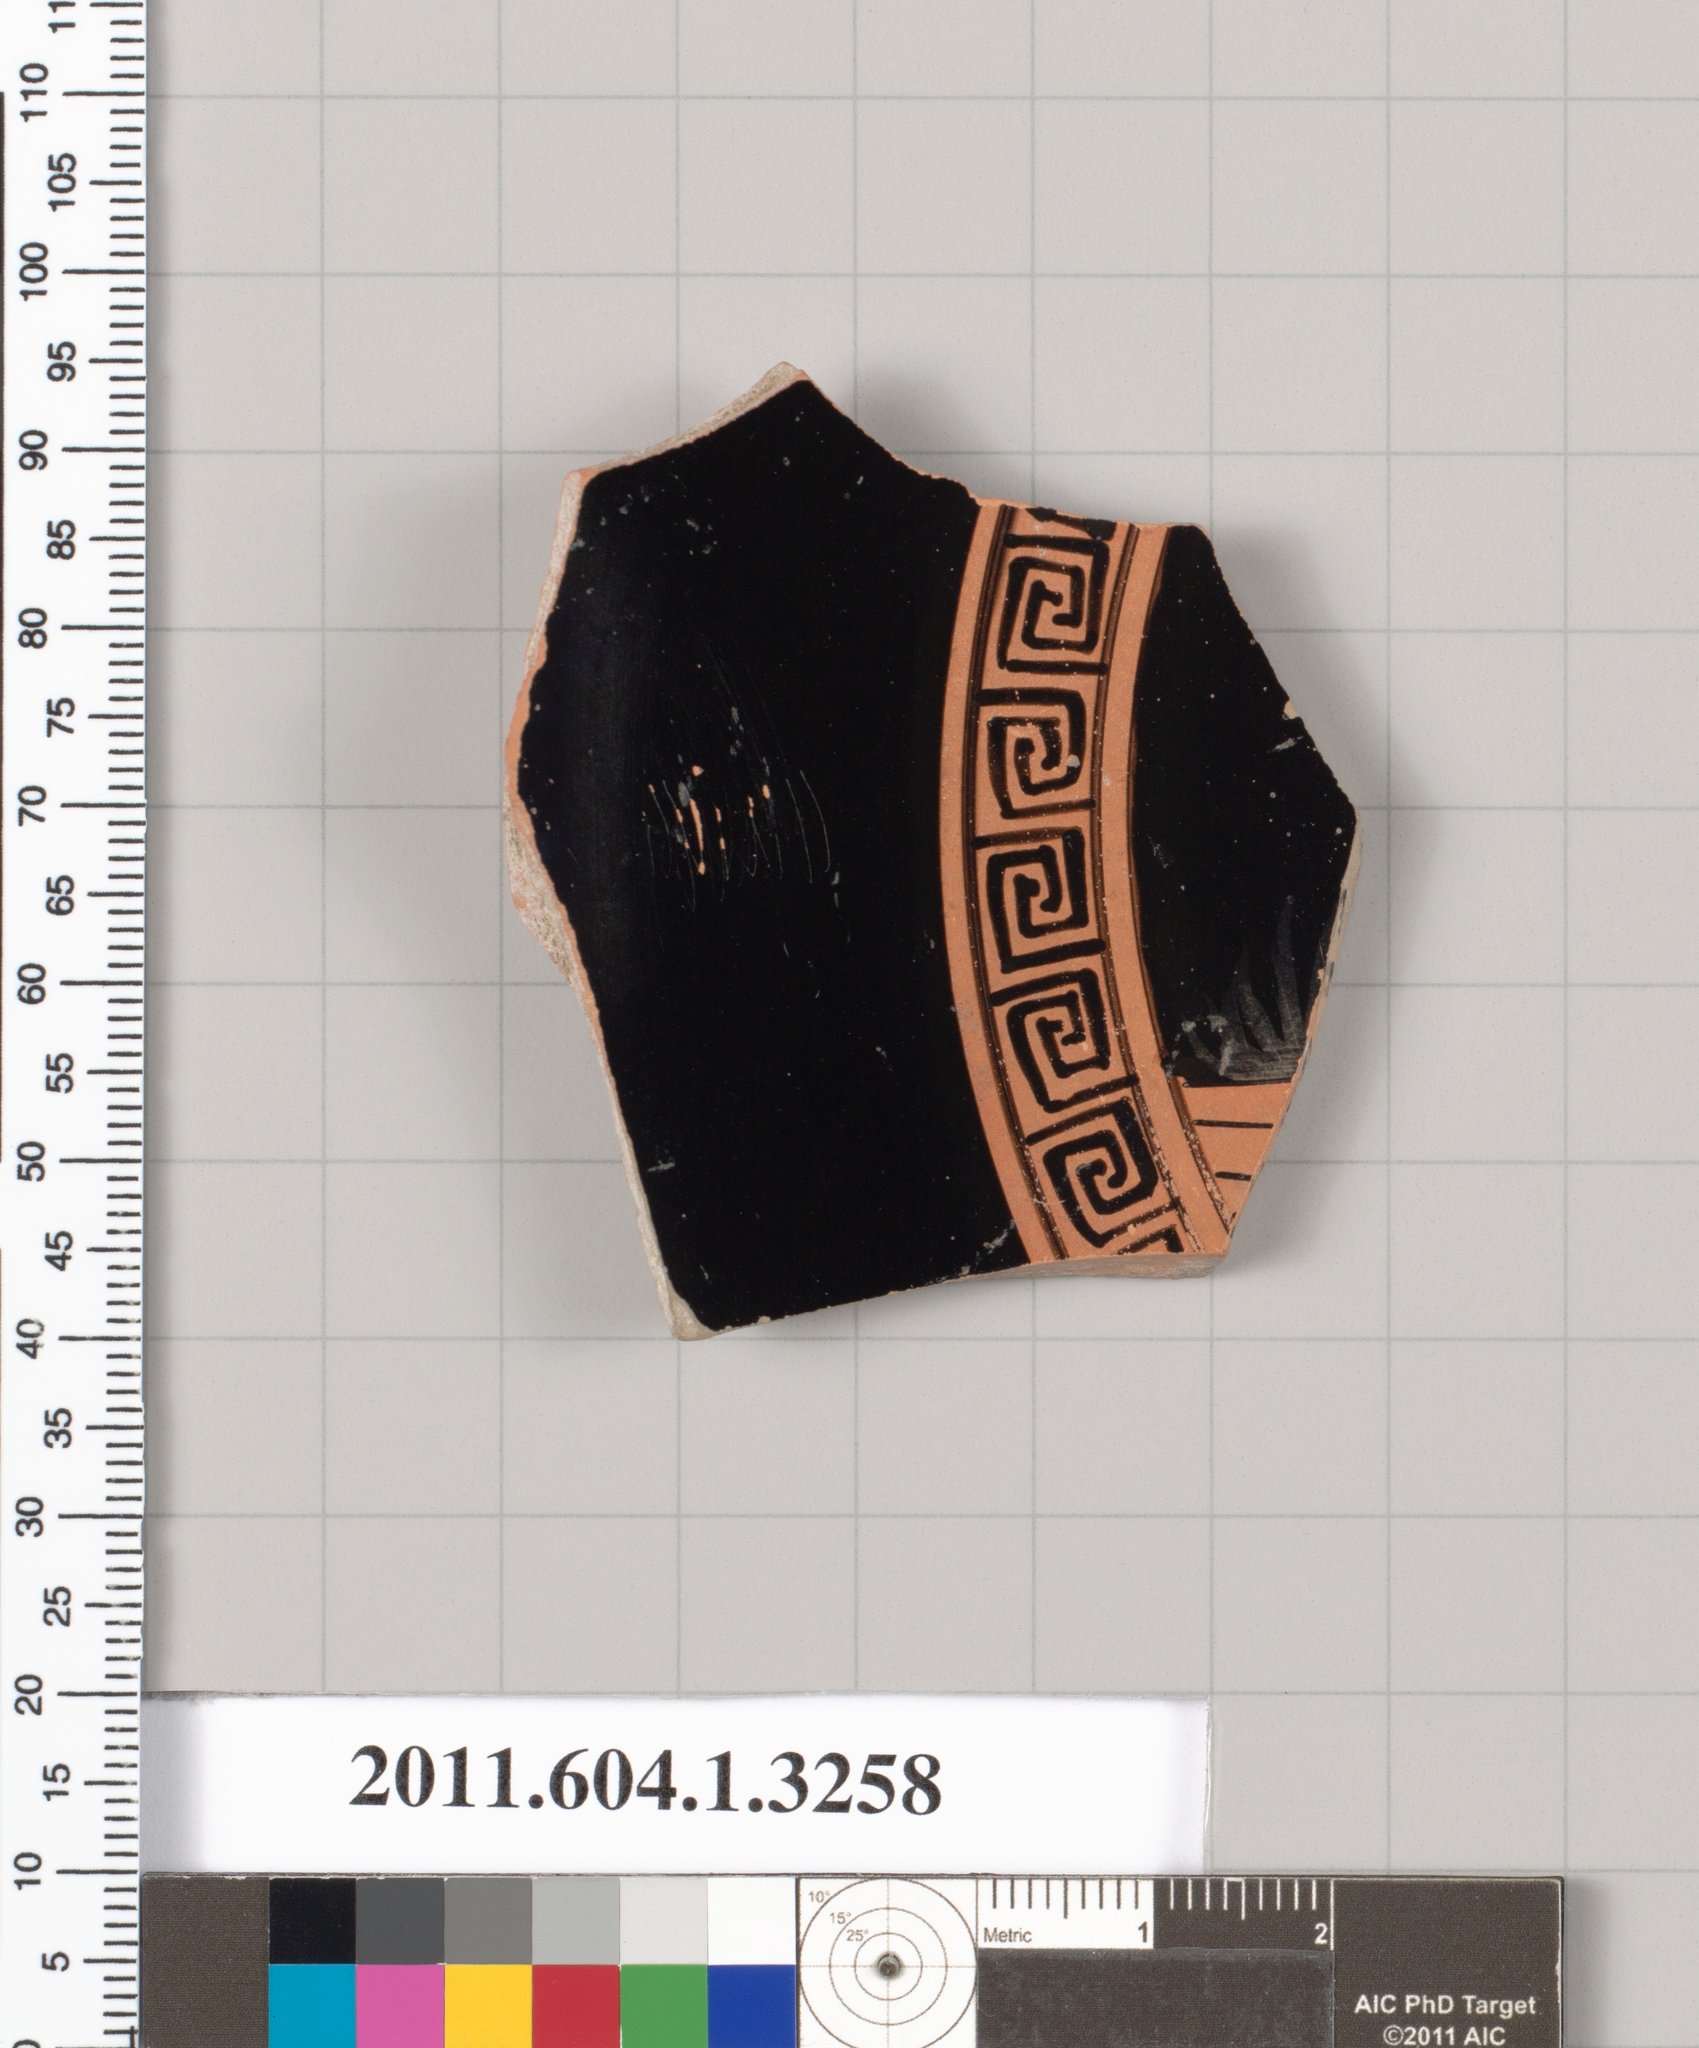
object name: kylix fragment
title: Terracotta fragment of a kylix (drinking cup)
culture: greek, attic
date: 490-480 BCE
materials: terracotta